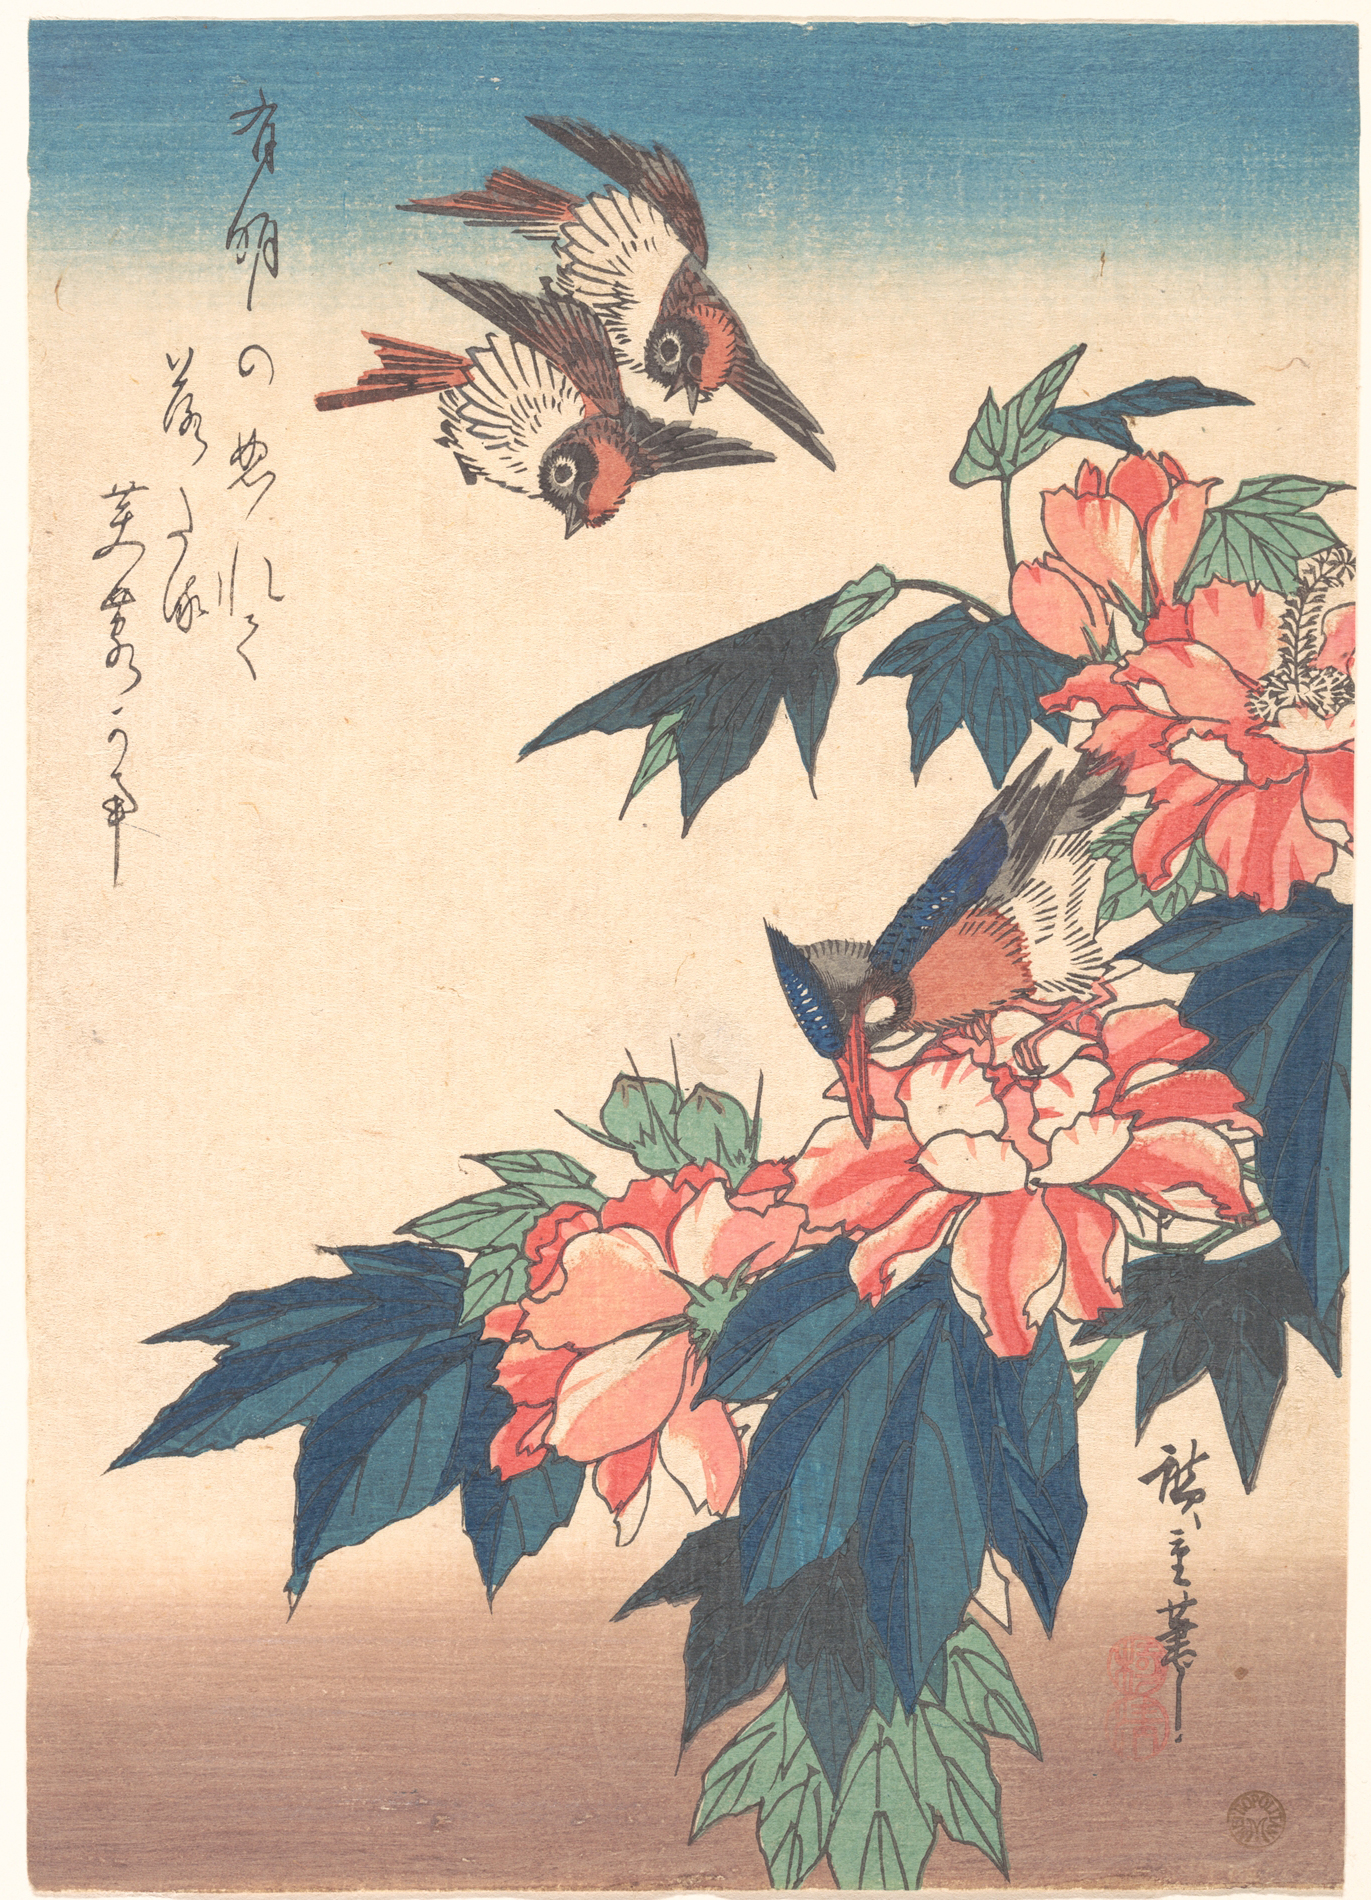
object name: woodblock print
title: Swallows and Kingfisher with Rose Mallows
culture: japanese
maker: utagawa hiroshige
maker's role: artist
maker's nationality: japanese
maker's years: 1797-1858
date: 1838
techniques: woodblock print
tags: birds,flowers,leaves